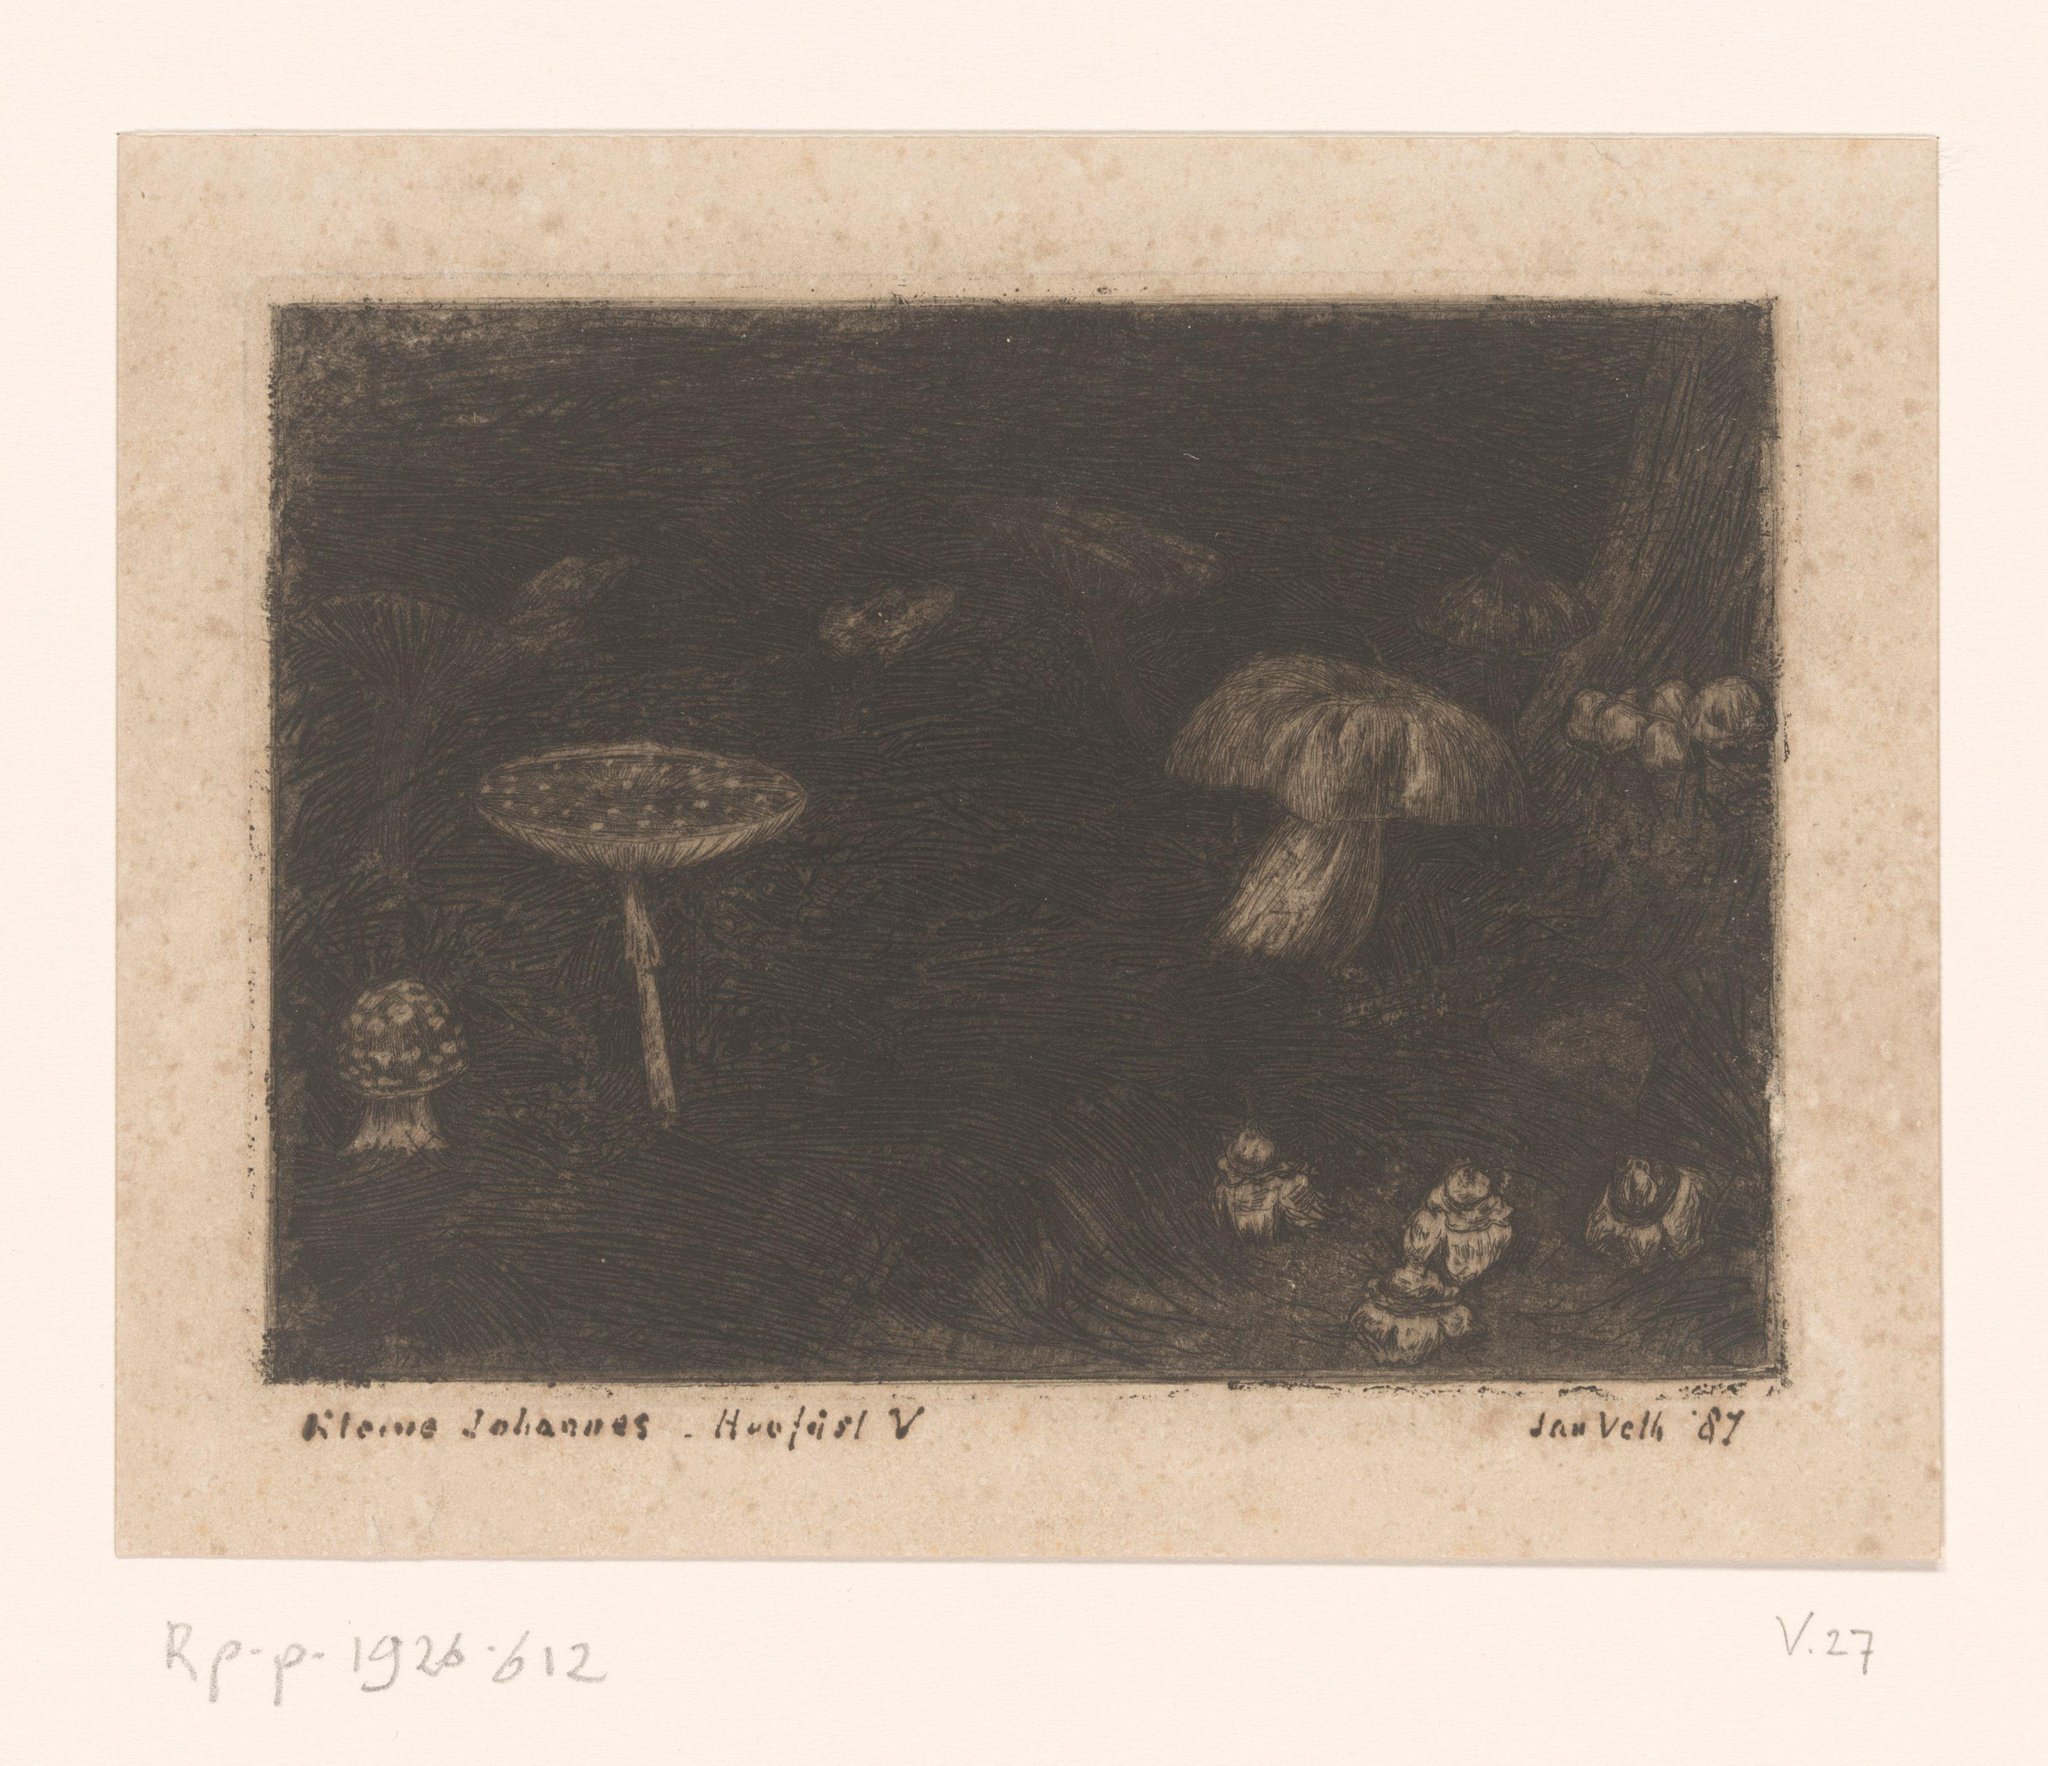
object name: print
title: Paddenstoelen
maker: jan veth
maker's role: designer, draughtsman, painter, print maker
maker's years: 1864-1925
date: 1887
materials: paper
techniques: etching, intaglio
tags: mushrooms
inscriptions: collector's mark: Lugt 2228, annotation: ‘Kleine Johannes - Hoofdst V’